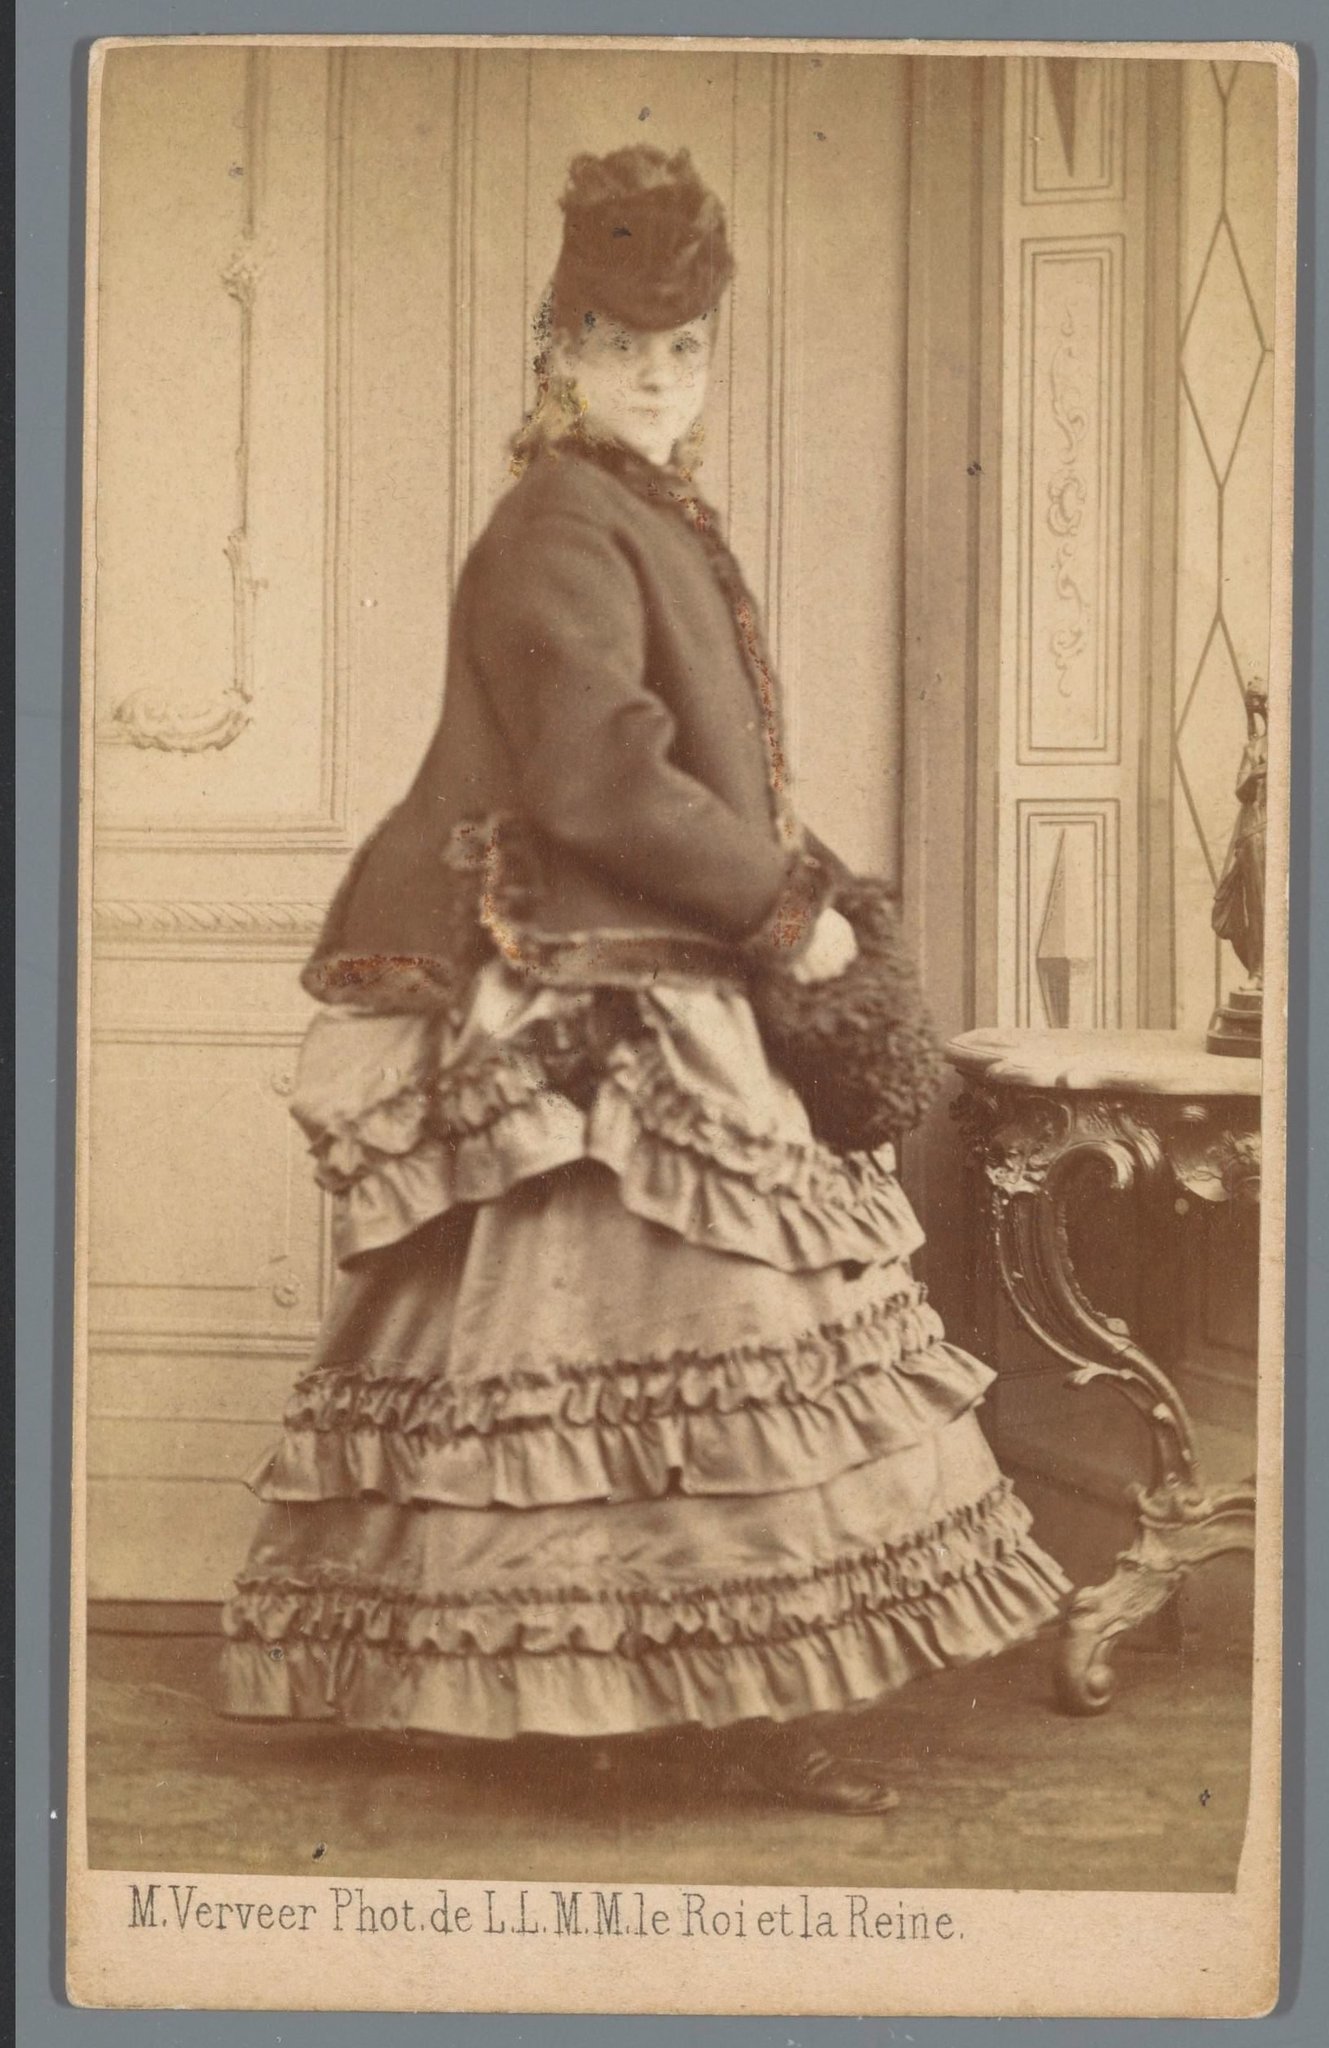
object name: carte de visite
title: Portret van een onbekende vrouw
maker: maurits verveer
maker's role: painter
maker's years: 1817-1903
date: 1861-1883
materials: cardboard, paper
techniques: albumen print, hand coloring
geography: the hague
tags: adult woman, anonymous historical person portrayed, the hague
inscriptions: inscription: ‘M. Verveer/ Photographe/ de L.L.M.M. le Roi et la Reine des Pays-Bas/ 52, Zeestraat 52./ Vis a vis du Willemspark/ La Haye’, number: ‘15,-’, inscription: ‘M. Verveer Phot. de S.M. le Roi’